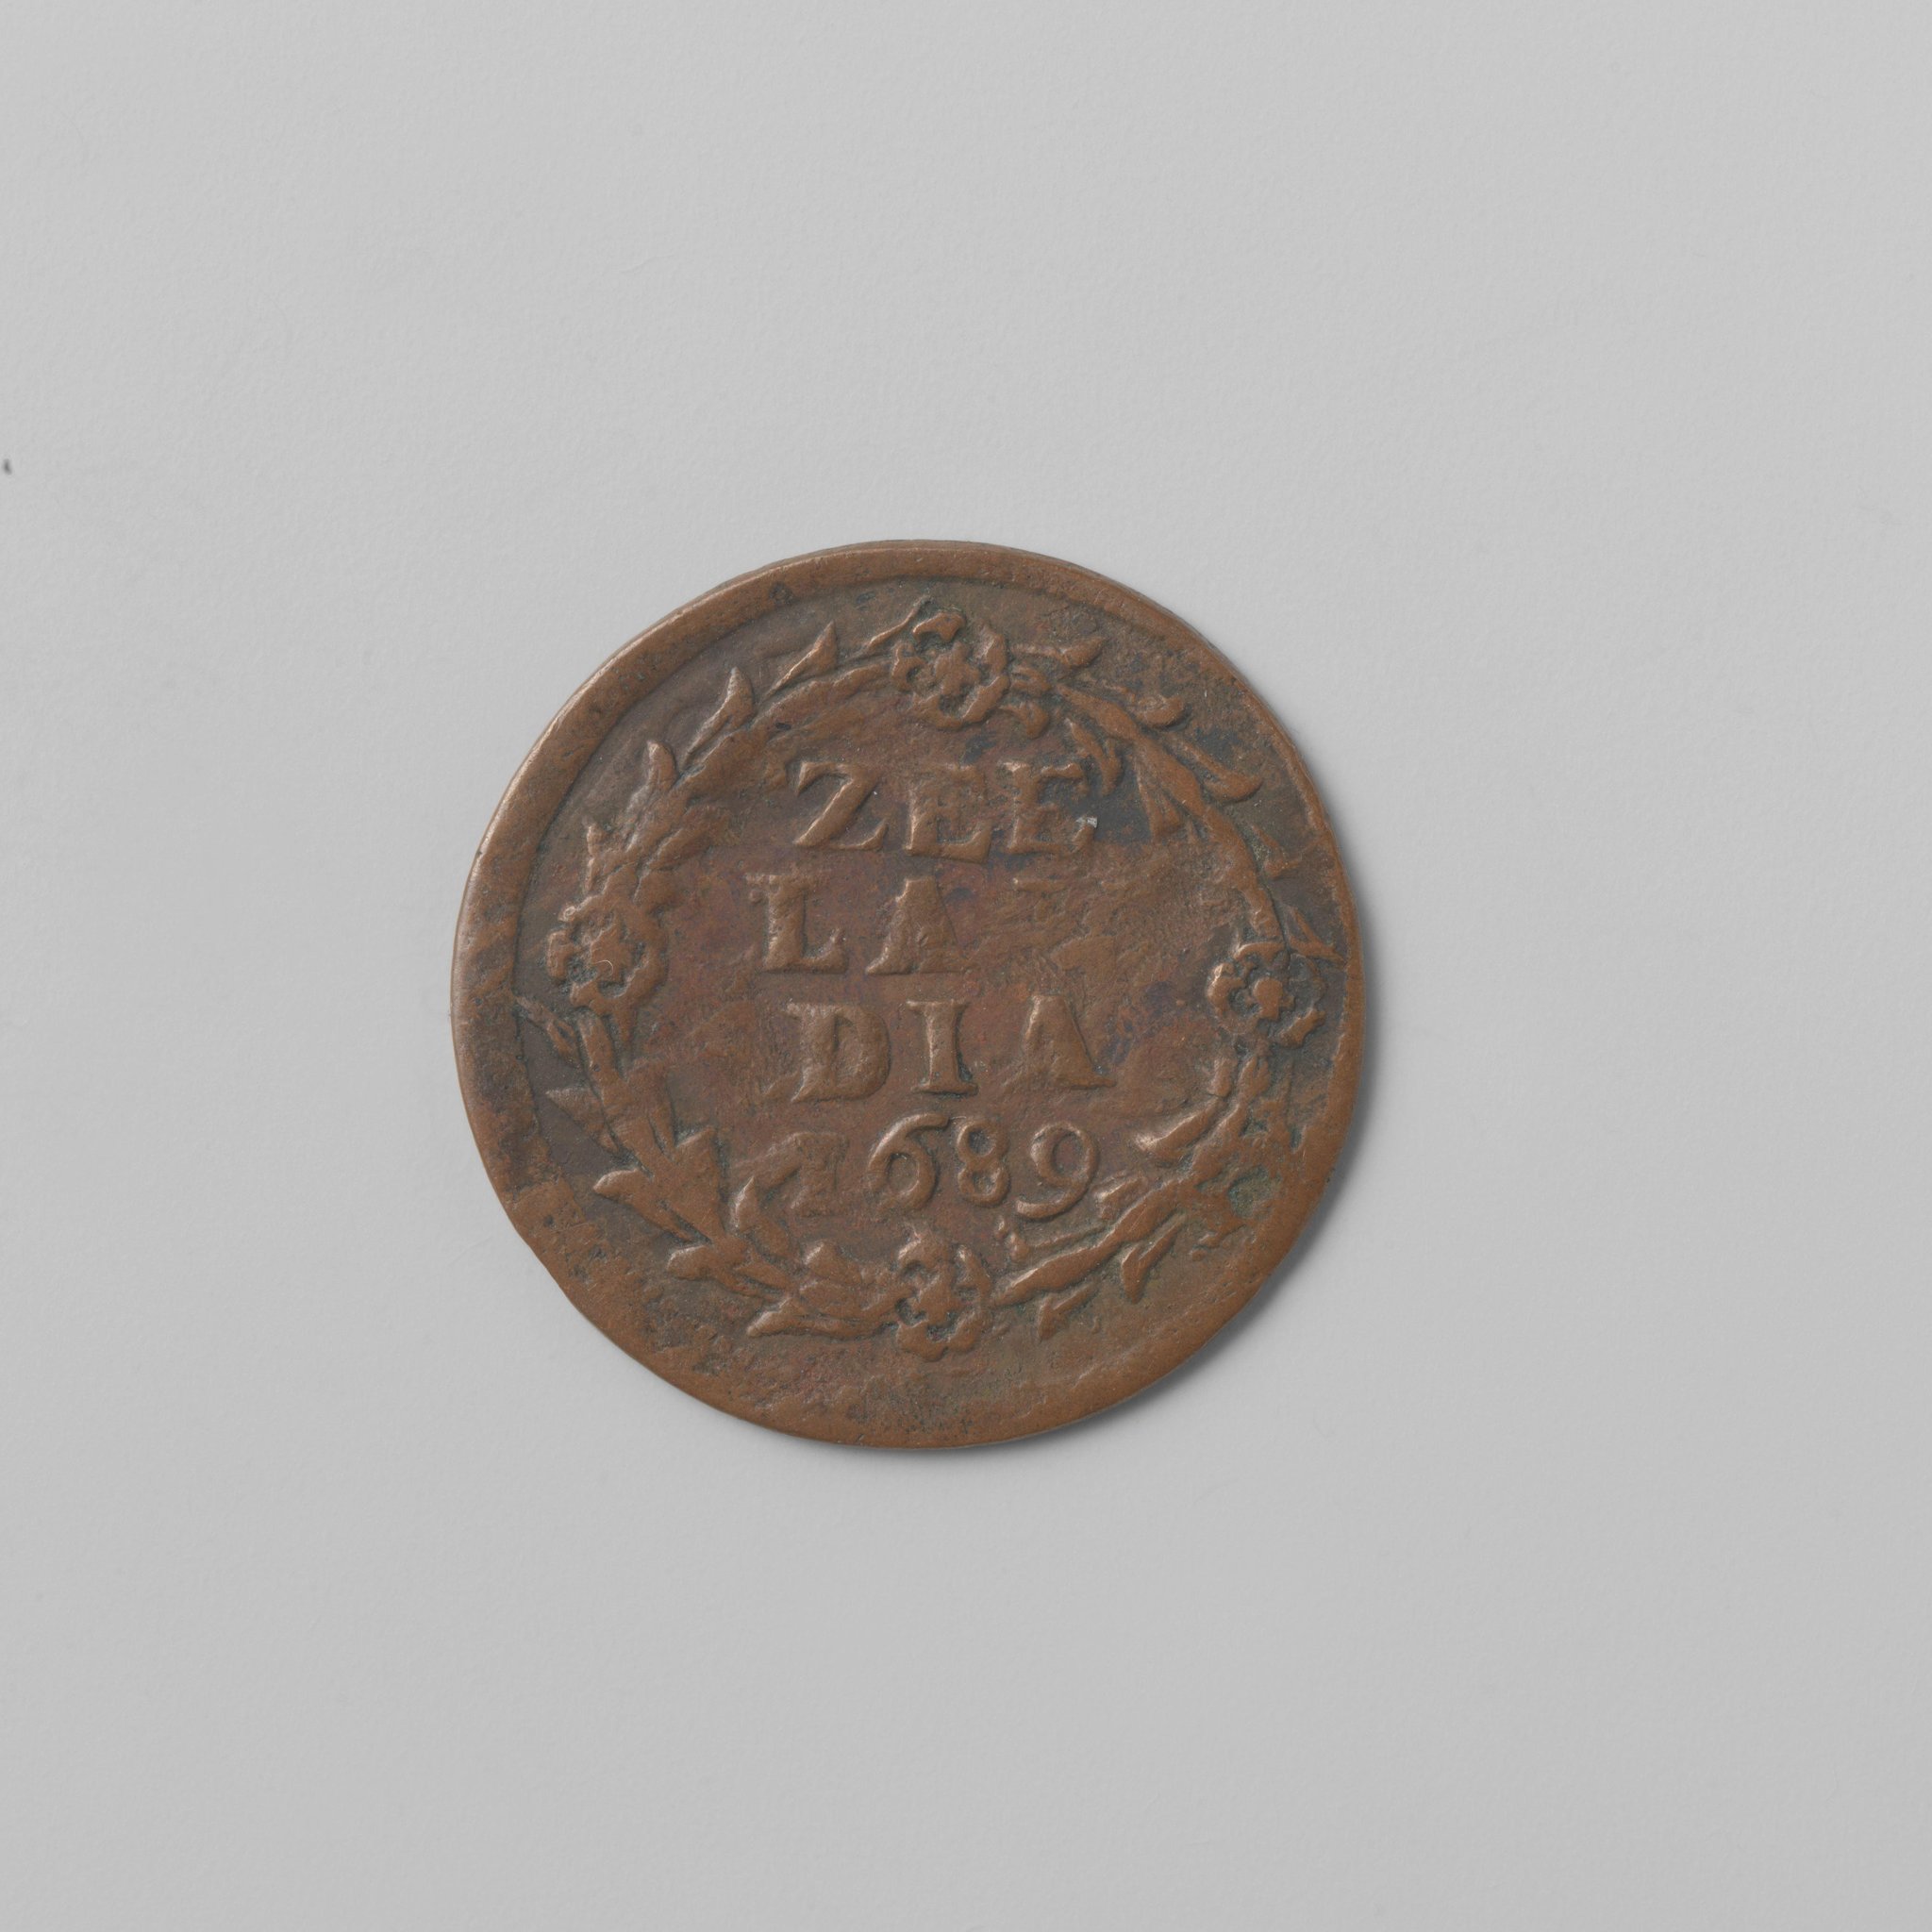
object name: coin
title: Zeeland, duit, 1689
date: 1689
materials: copper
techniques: striking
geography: middelburg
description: Koperen munt. Voorzijde: maagd zittend achter gekroond wapenschild van Zeeland in eeen tuin met gesloten omheining. Keerzijde: binnen bladerkrans opschrift in drie regels, waaronder jaartal..